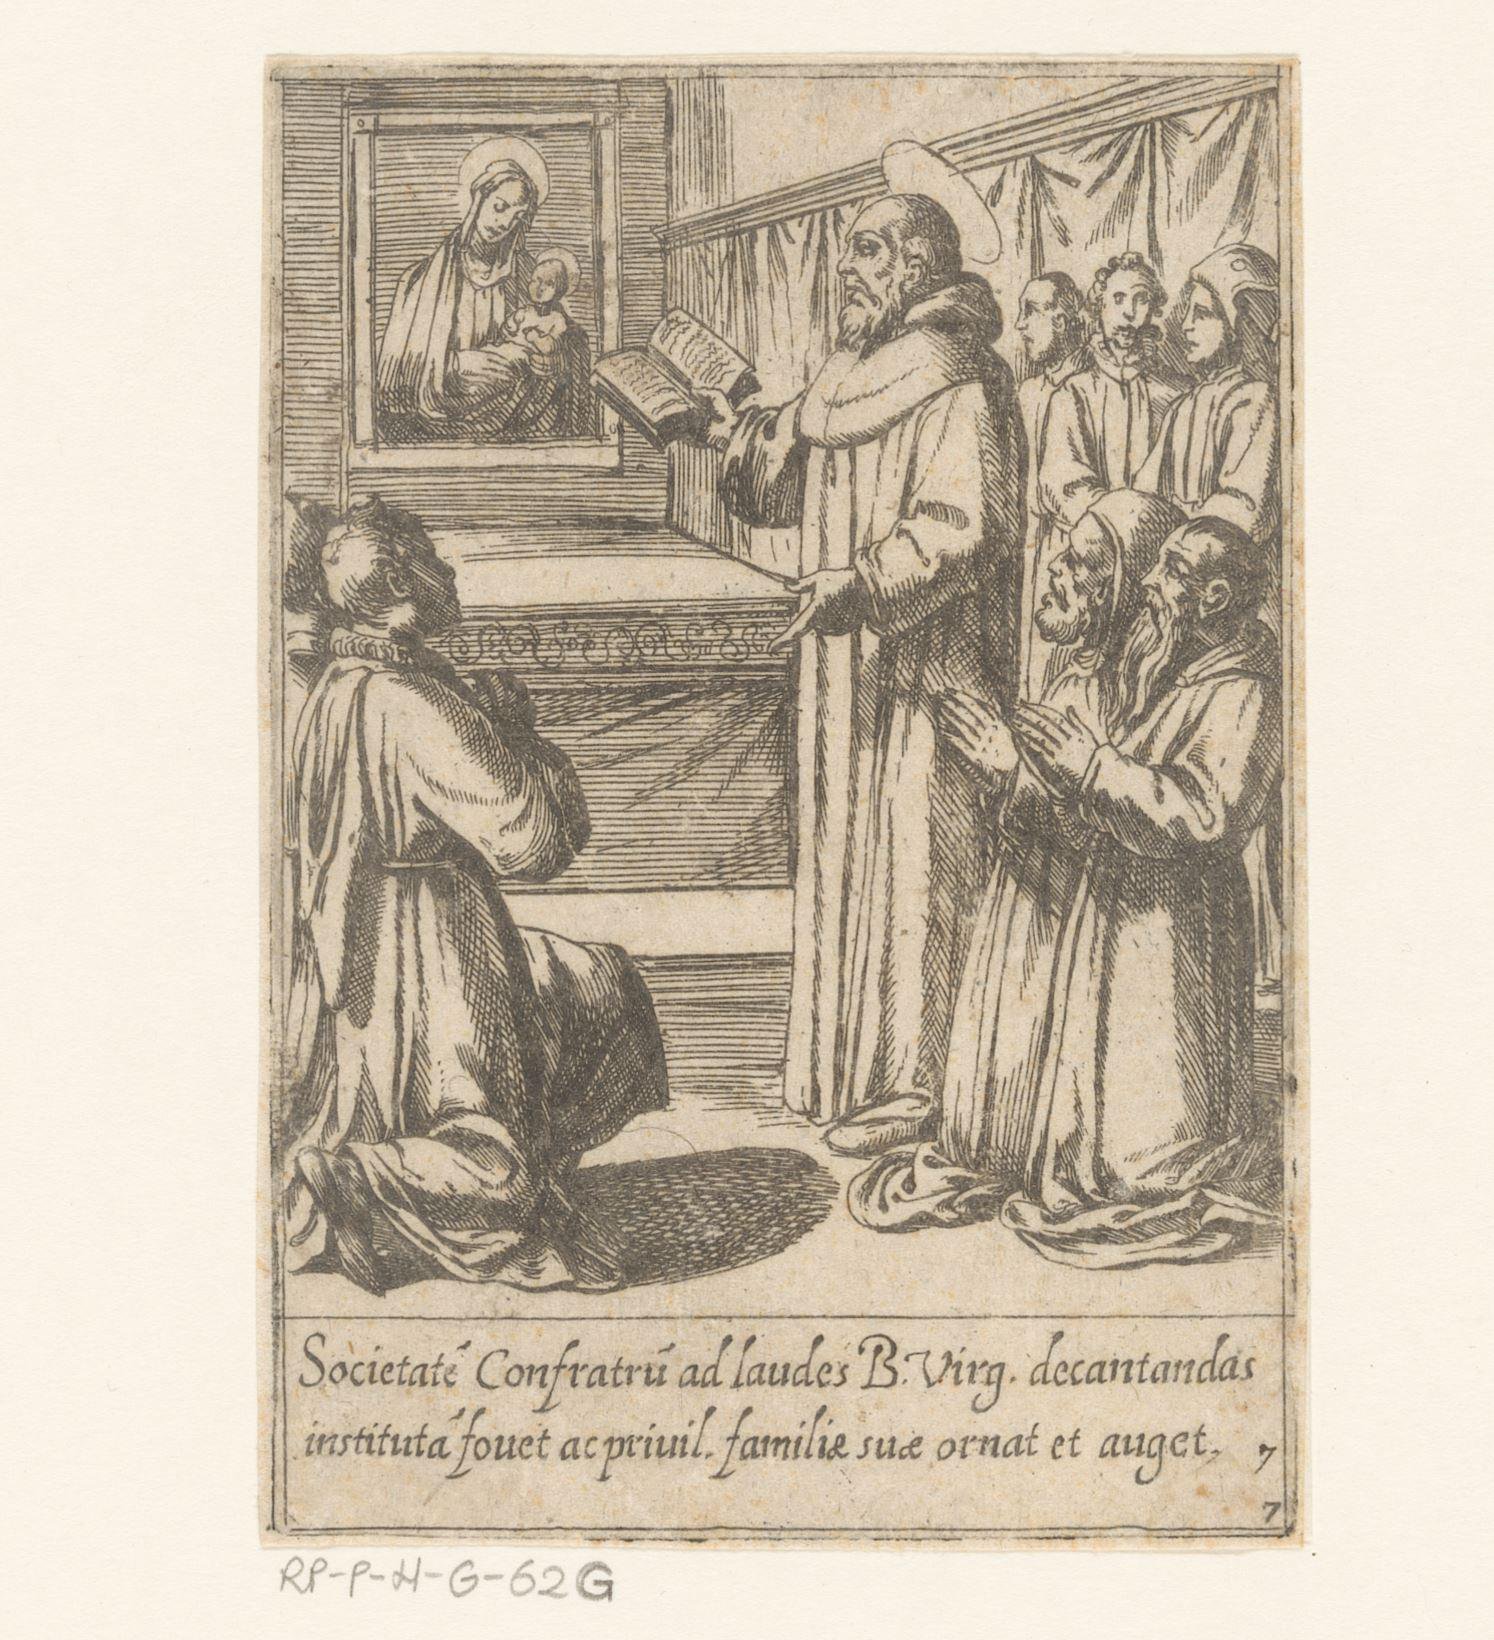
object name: print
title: Vita B. Philippi Benicii Florent. ord. servor B. Mariae virginis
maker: antonio tempesta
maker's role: draughtsman, painter, print maker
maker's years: 1555-1630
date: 1591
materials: paper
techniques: etching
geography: vatican city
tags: clergyman, (public) prayer, prior general of the order of the servites, philip benizzi of florence; possible attributes: book, cross, lily, tiara at his feet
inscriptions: collector's mark: ‘Hinloopen’, number: ‘7’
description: De heilige Philippus gaat voor in gebed als hoofd van de servieten. Tekst in het Latijn in ondermarge. Genummerd rechtsonder: 7.